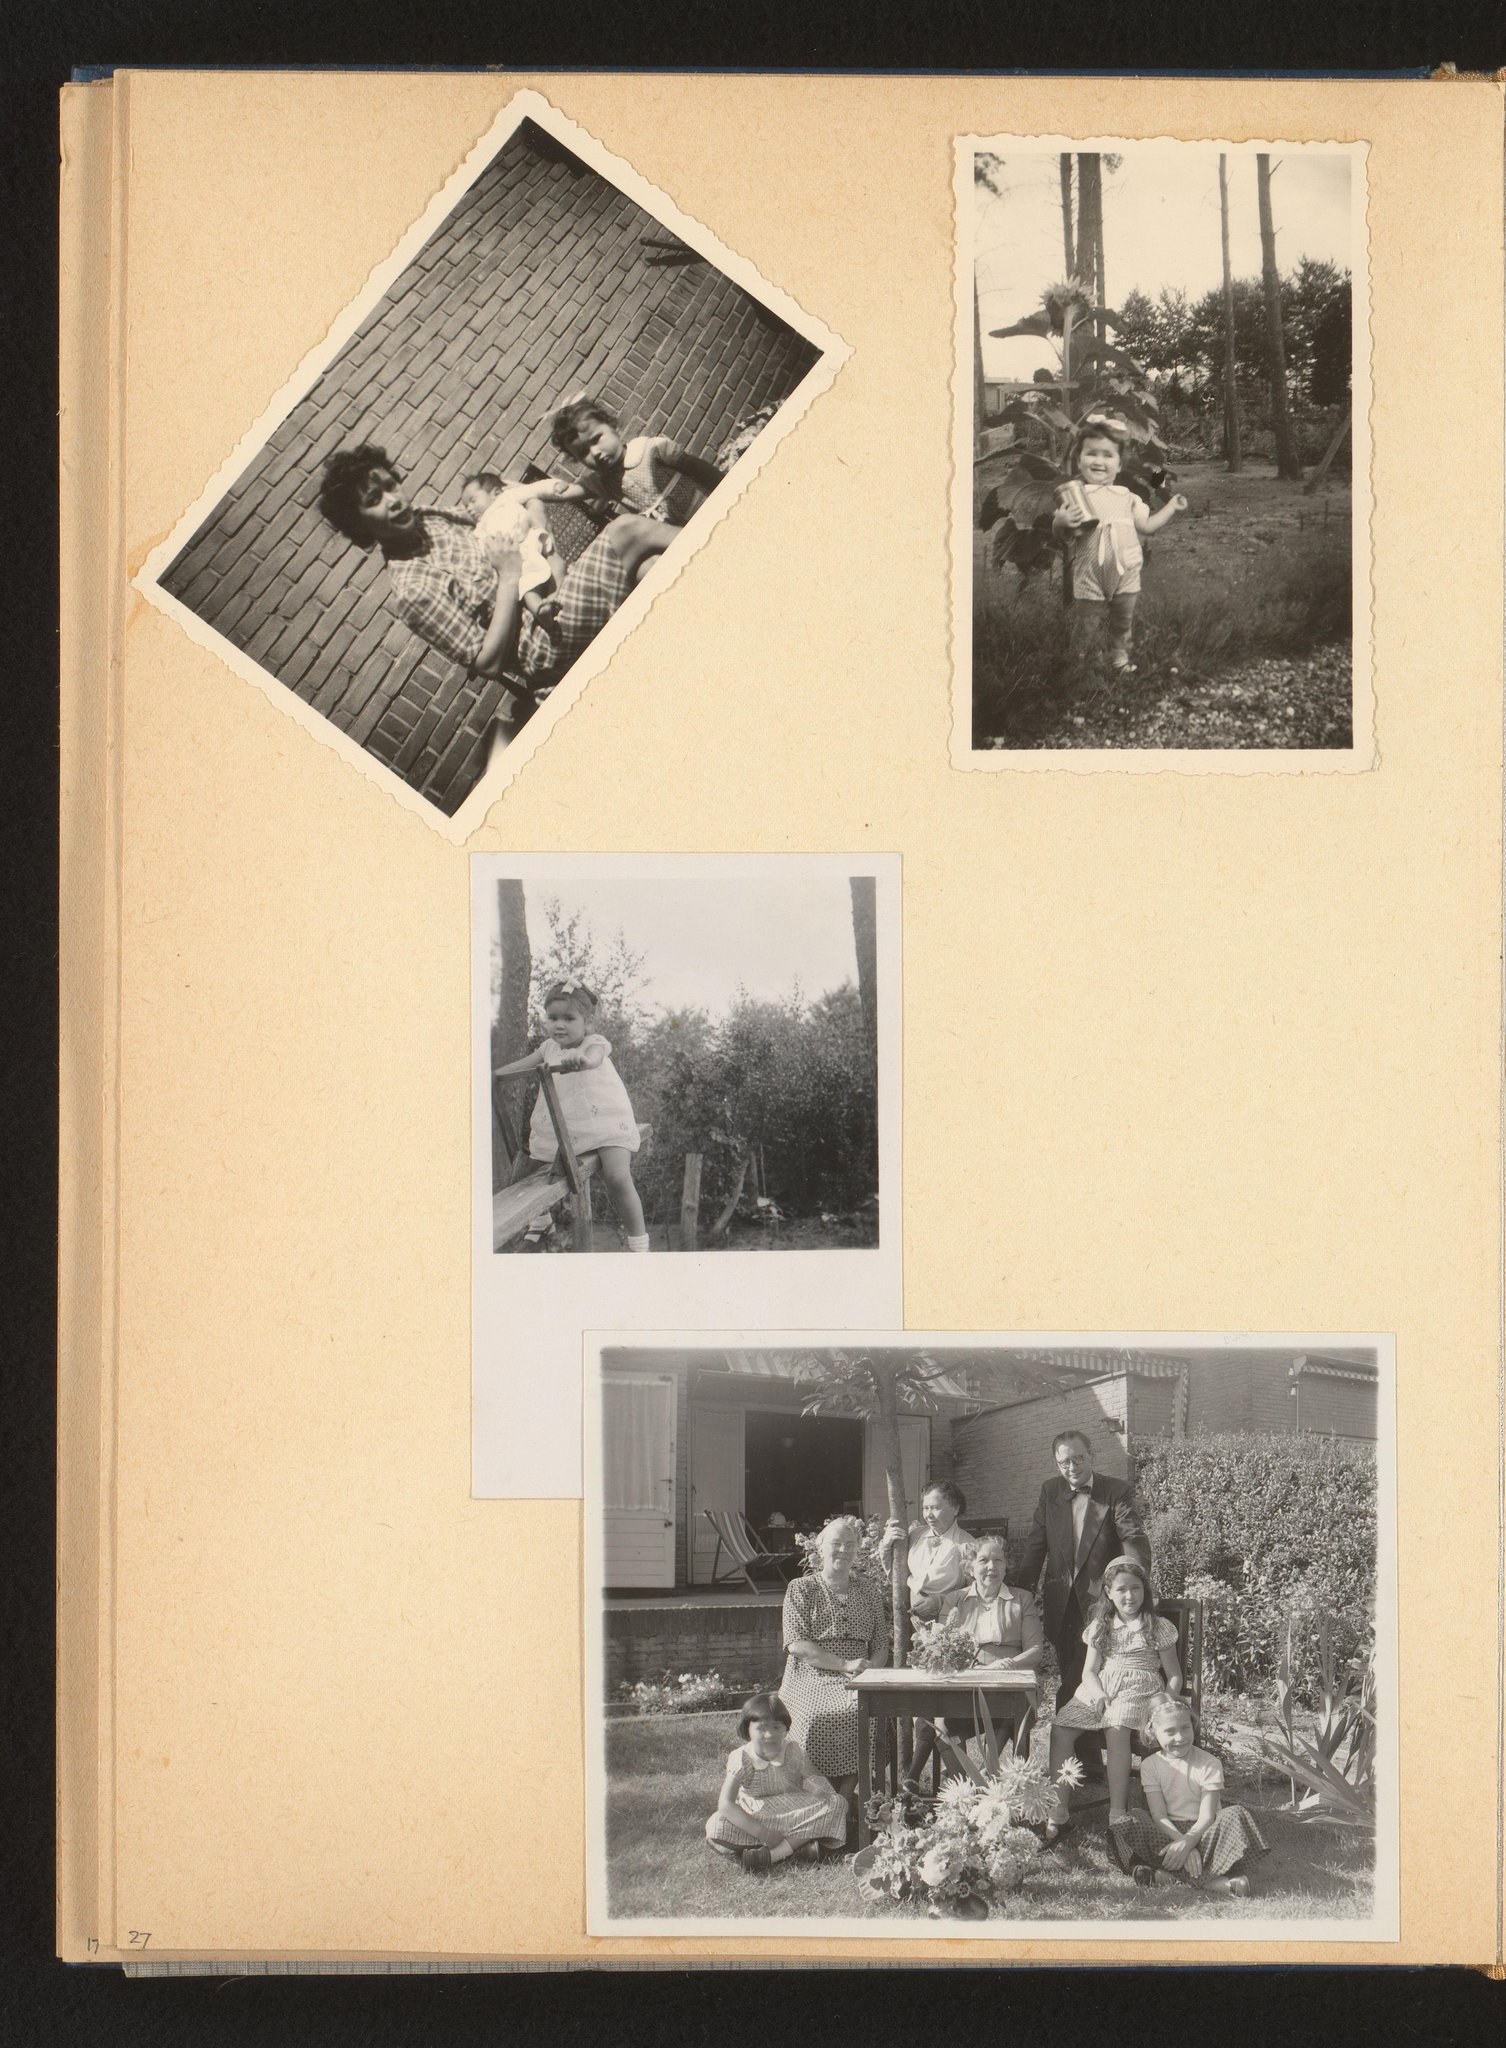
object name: photograph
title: Eef Dumas en dochters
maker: Anonymous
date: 1946-1952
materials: cardboard, photographic support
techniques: gelatin silver print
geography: netherlands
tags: surabaya, paris, beatrice jacqueline eveline dumas, amsterdam, max nord, historical persons - bb - woman, playing toddler; child amusing itself - aa - girl, historical persons, netherlands, dutch east indies, the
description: Blad met vier foto's van Eef Dumas met haar twee dochters en een familiefoto genomen in de tuin. Onderdeel van het fotoalbum van Beatrice Jacqueline Eveline (Eef) Dumas, ca. 1880-1952.